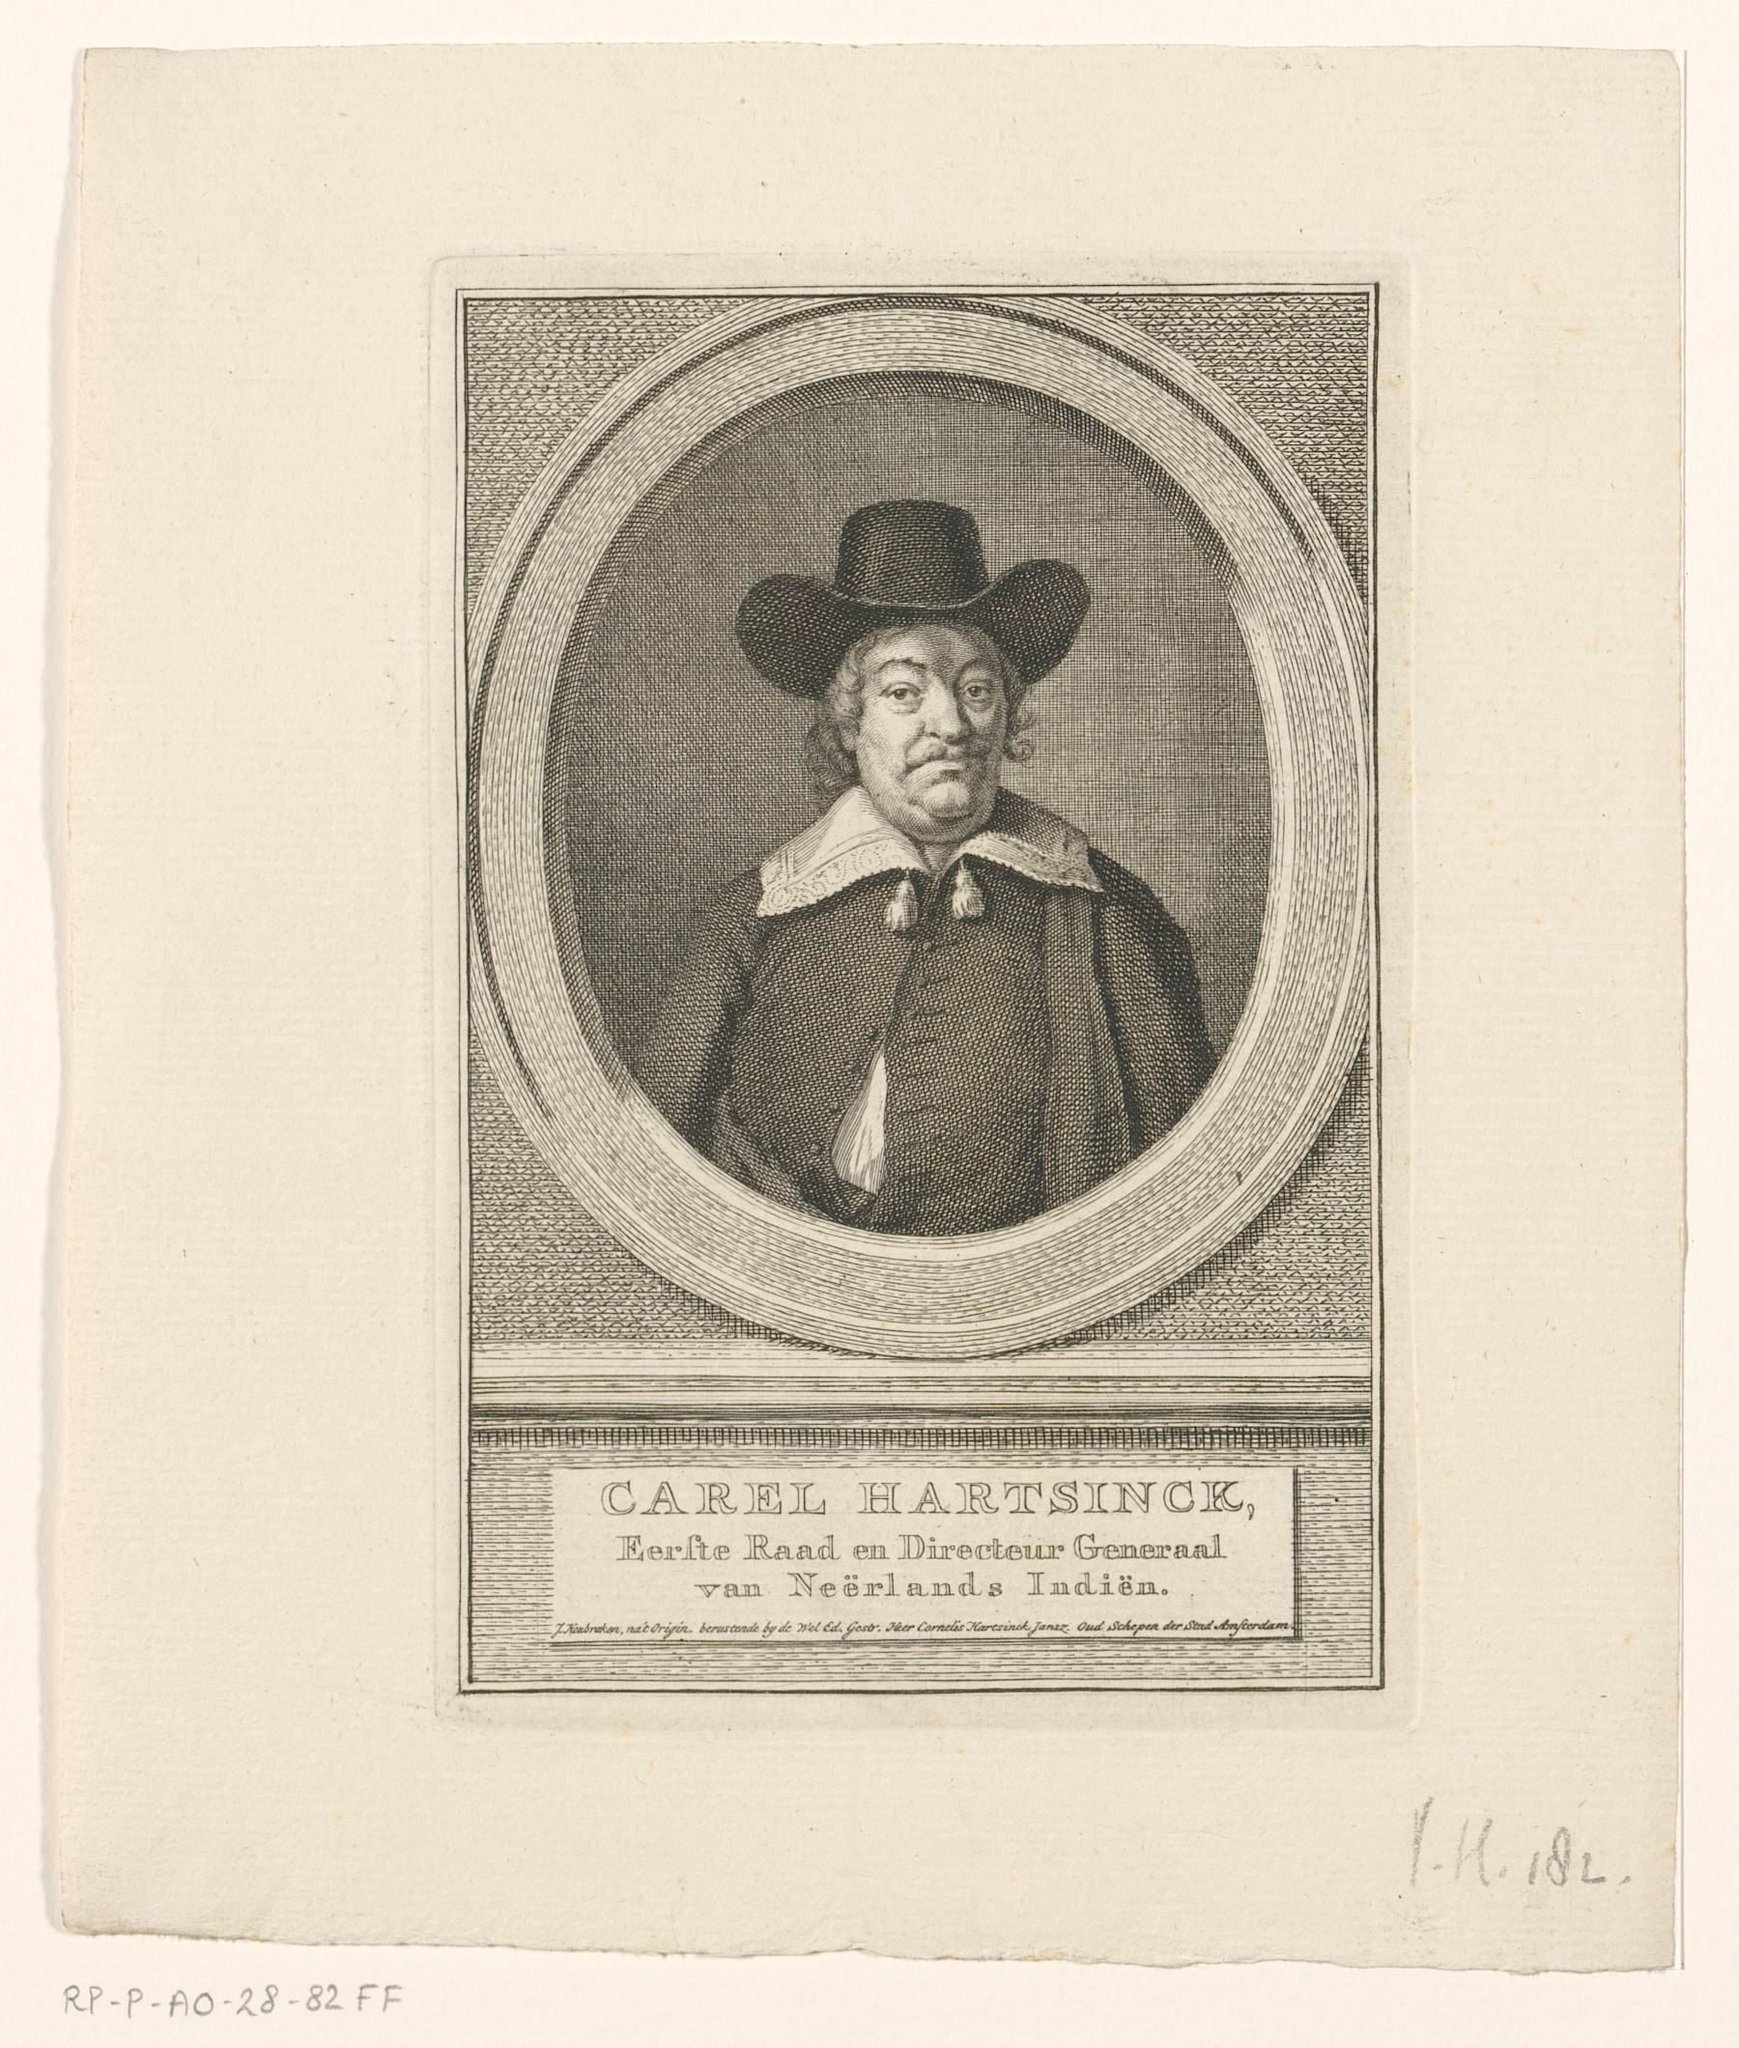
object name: print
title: Portret van Willem Carel Hartsinck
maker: jacob houbraken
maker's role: draughtsman, print maker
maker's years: 1698-1780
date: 1749-1780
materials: paper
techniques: engraving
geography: amsterdam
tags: historical persons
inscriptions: collector's mark: Lugt 2228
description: Deze prent is oorspronkelijk bedoeld als aanvulling op Jan Wagenaars ‘Vaderlandsche historie’* en was zo vanaf 1796 verkrijgbaar bij Johannes Allart te Amsterdam. Voor de advertentie waarin Allart de 60 portretten en 7 platen, allen gegraveerd door Houbraken, ter aanvulling op Wagenaars ‘Vaderlandsche historie’ aanbiedt, zie RP-P-OB-77.766. *Van dit werk zijn in de achttiende eeuw meerdere uitgaves verschenen, zoals: Wagenaar, Jan. Vaderlandsche historie, vervattende de geschiedenissen der Vereenigde Nederlanden (…). 21 delen. Amsterdam: Isaak Tirion, 1749-1759. Wagenaar, Jan. Vaderlandsche historie, vervattende de geschiedenissen der nu Vereenigde Nederlanden (…). 21 delen. Amsterdam: weduwe Isaak Tirion, 1770. Wagenaar, Jan. Vaderlandsche historie, vervattende de geschiedenissen der nu Vereenigde Nederlanden (…). 21 delen. Amsterdam, Leiden, Dordrecht en Harlingen: P. Schouten e.a., 1782. Wagenaar, Jan. Vaderlandsche historie, vervattende de geschiedenissen der nu Vereenigde Nederlanden (…). 21 delen. Amsterdam: Johannes Allart, 1790-1796.